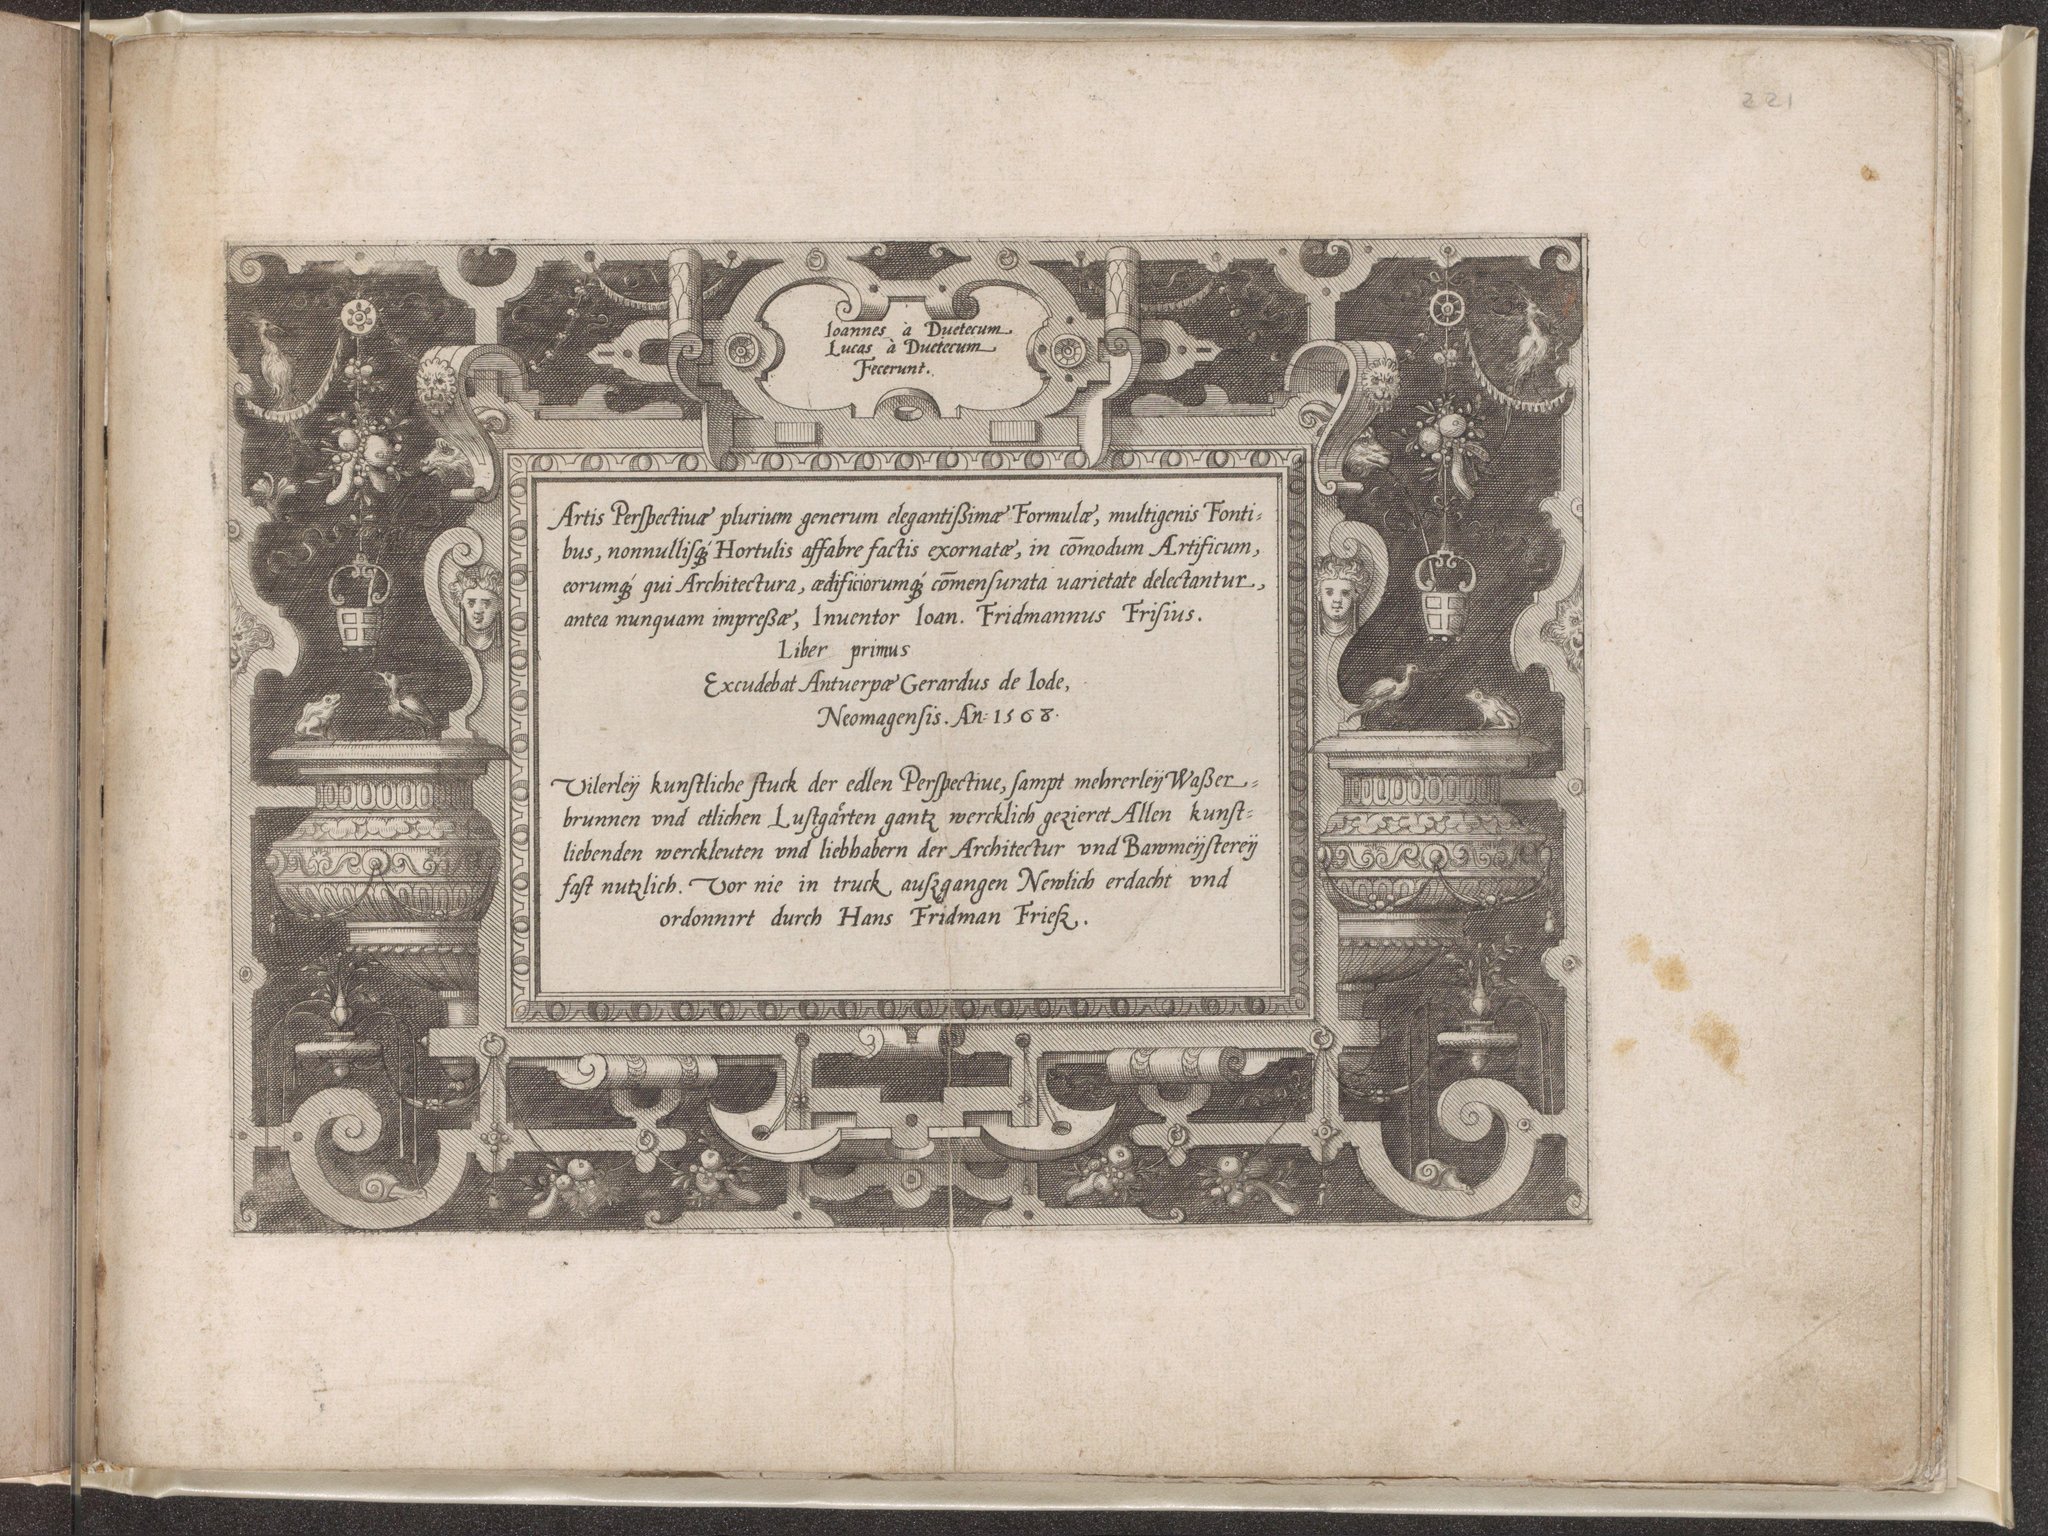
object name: print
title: Artis Perspectivae (...)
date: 1568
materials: paper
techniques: etching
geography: antwerp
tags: scrollwork, strapwork ~ ornament, ornament ~ cartouche, ornamental fountain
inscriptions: date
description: De titel van de prentserie 'Artis Perspectivae' op een cartouche in een ornamentele lijst. Rechts en links een vat met een kikker en een vogel op de rand. Deze prent maakt deel uit van een album.